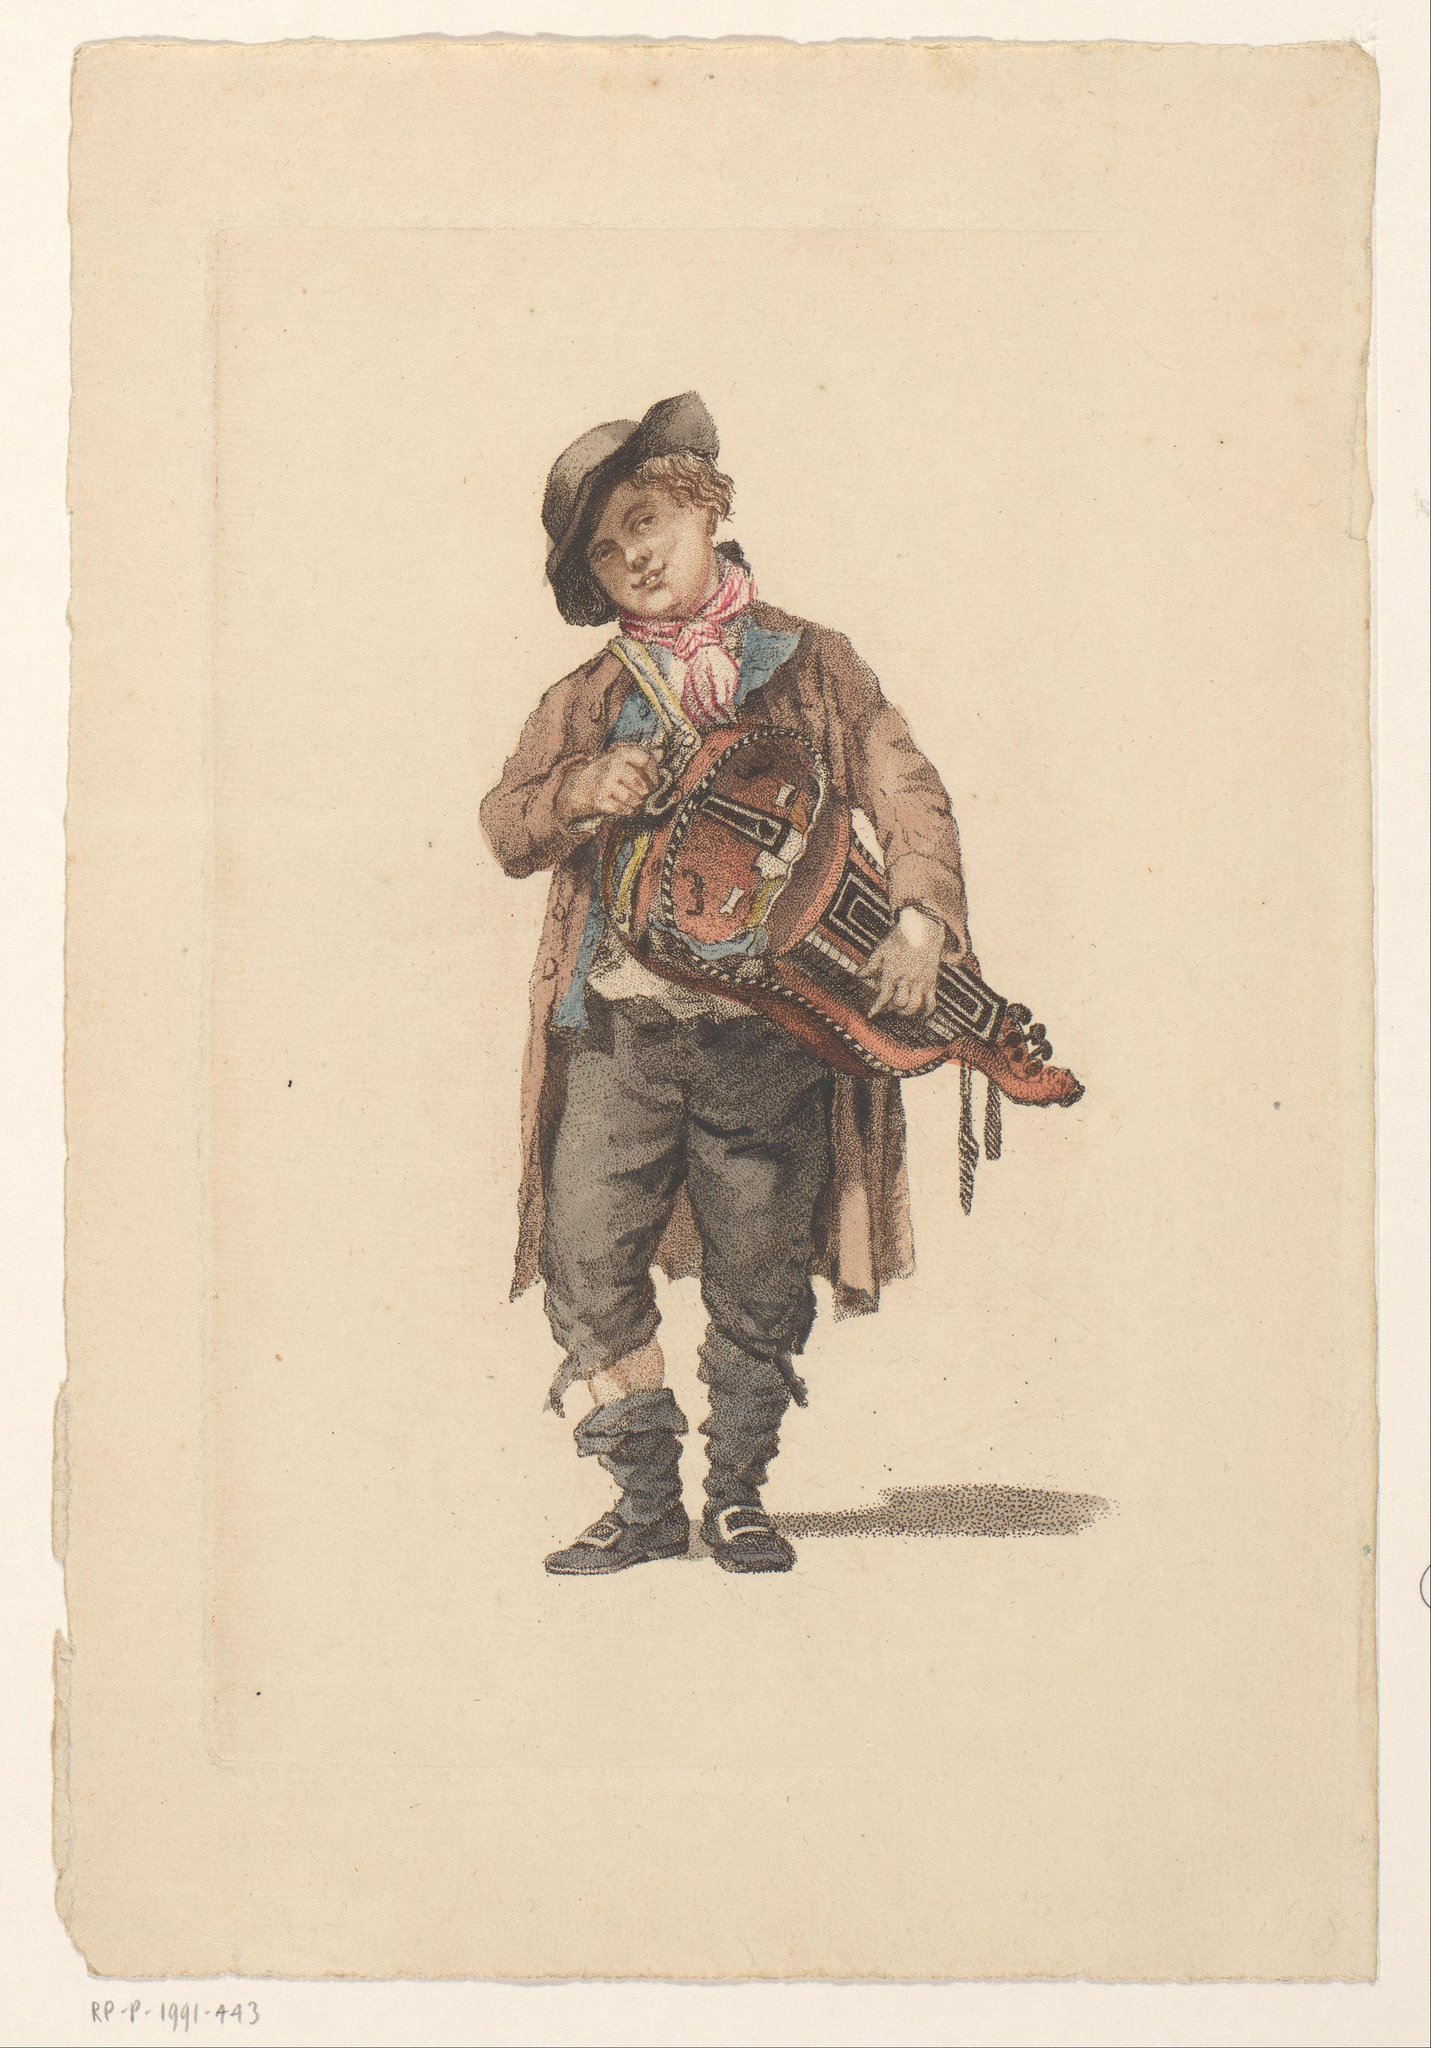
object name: print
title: Draailierspeler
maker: mathias de sallieth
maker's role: print maker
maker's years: 1749-1791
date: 1772-1791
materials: paper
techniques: printmaking, etching, hand coloring, lithography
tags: youth, adolescent, clothes, costume (+ men's clothes), hurdy-gurdy player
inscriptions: collector's mark: Lugt 2228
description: De prent verscheen vanaf 1818 tevens als onderdeel van een 33-delige reeks prenten door Mathias de Sallieth, samengebonden in: Perkois, Jacobus, Prins, Johannes Huibert. Verzameling van verschillende gekleede mans- en vrouwenstanden, ter oefening van jonge schilders en liefhebbers. Rotterdam: Johannes Immerzeel, 1818. Uit eerste oplage figuurstudies (zonder nummers). De plaat is verloren gegaan en daarna opnieuw met nummer vervaardigd (in spiegelbeeld), zie RP-P-OB-60.405.